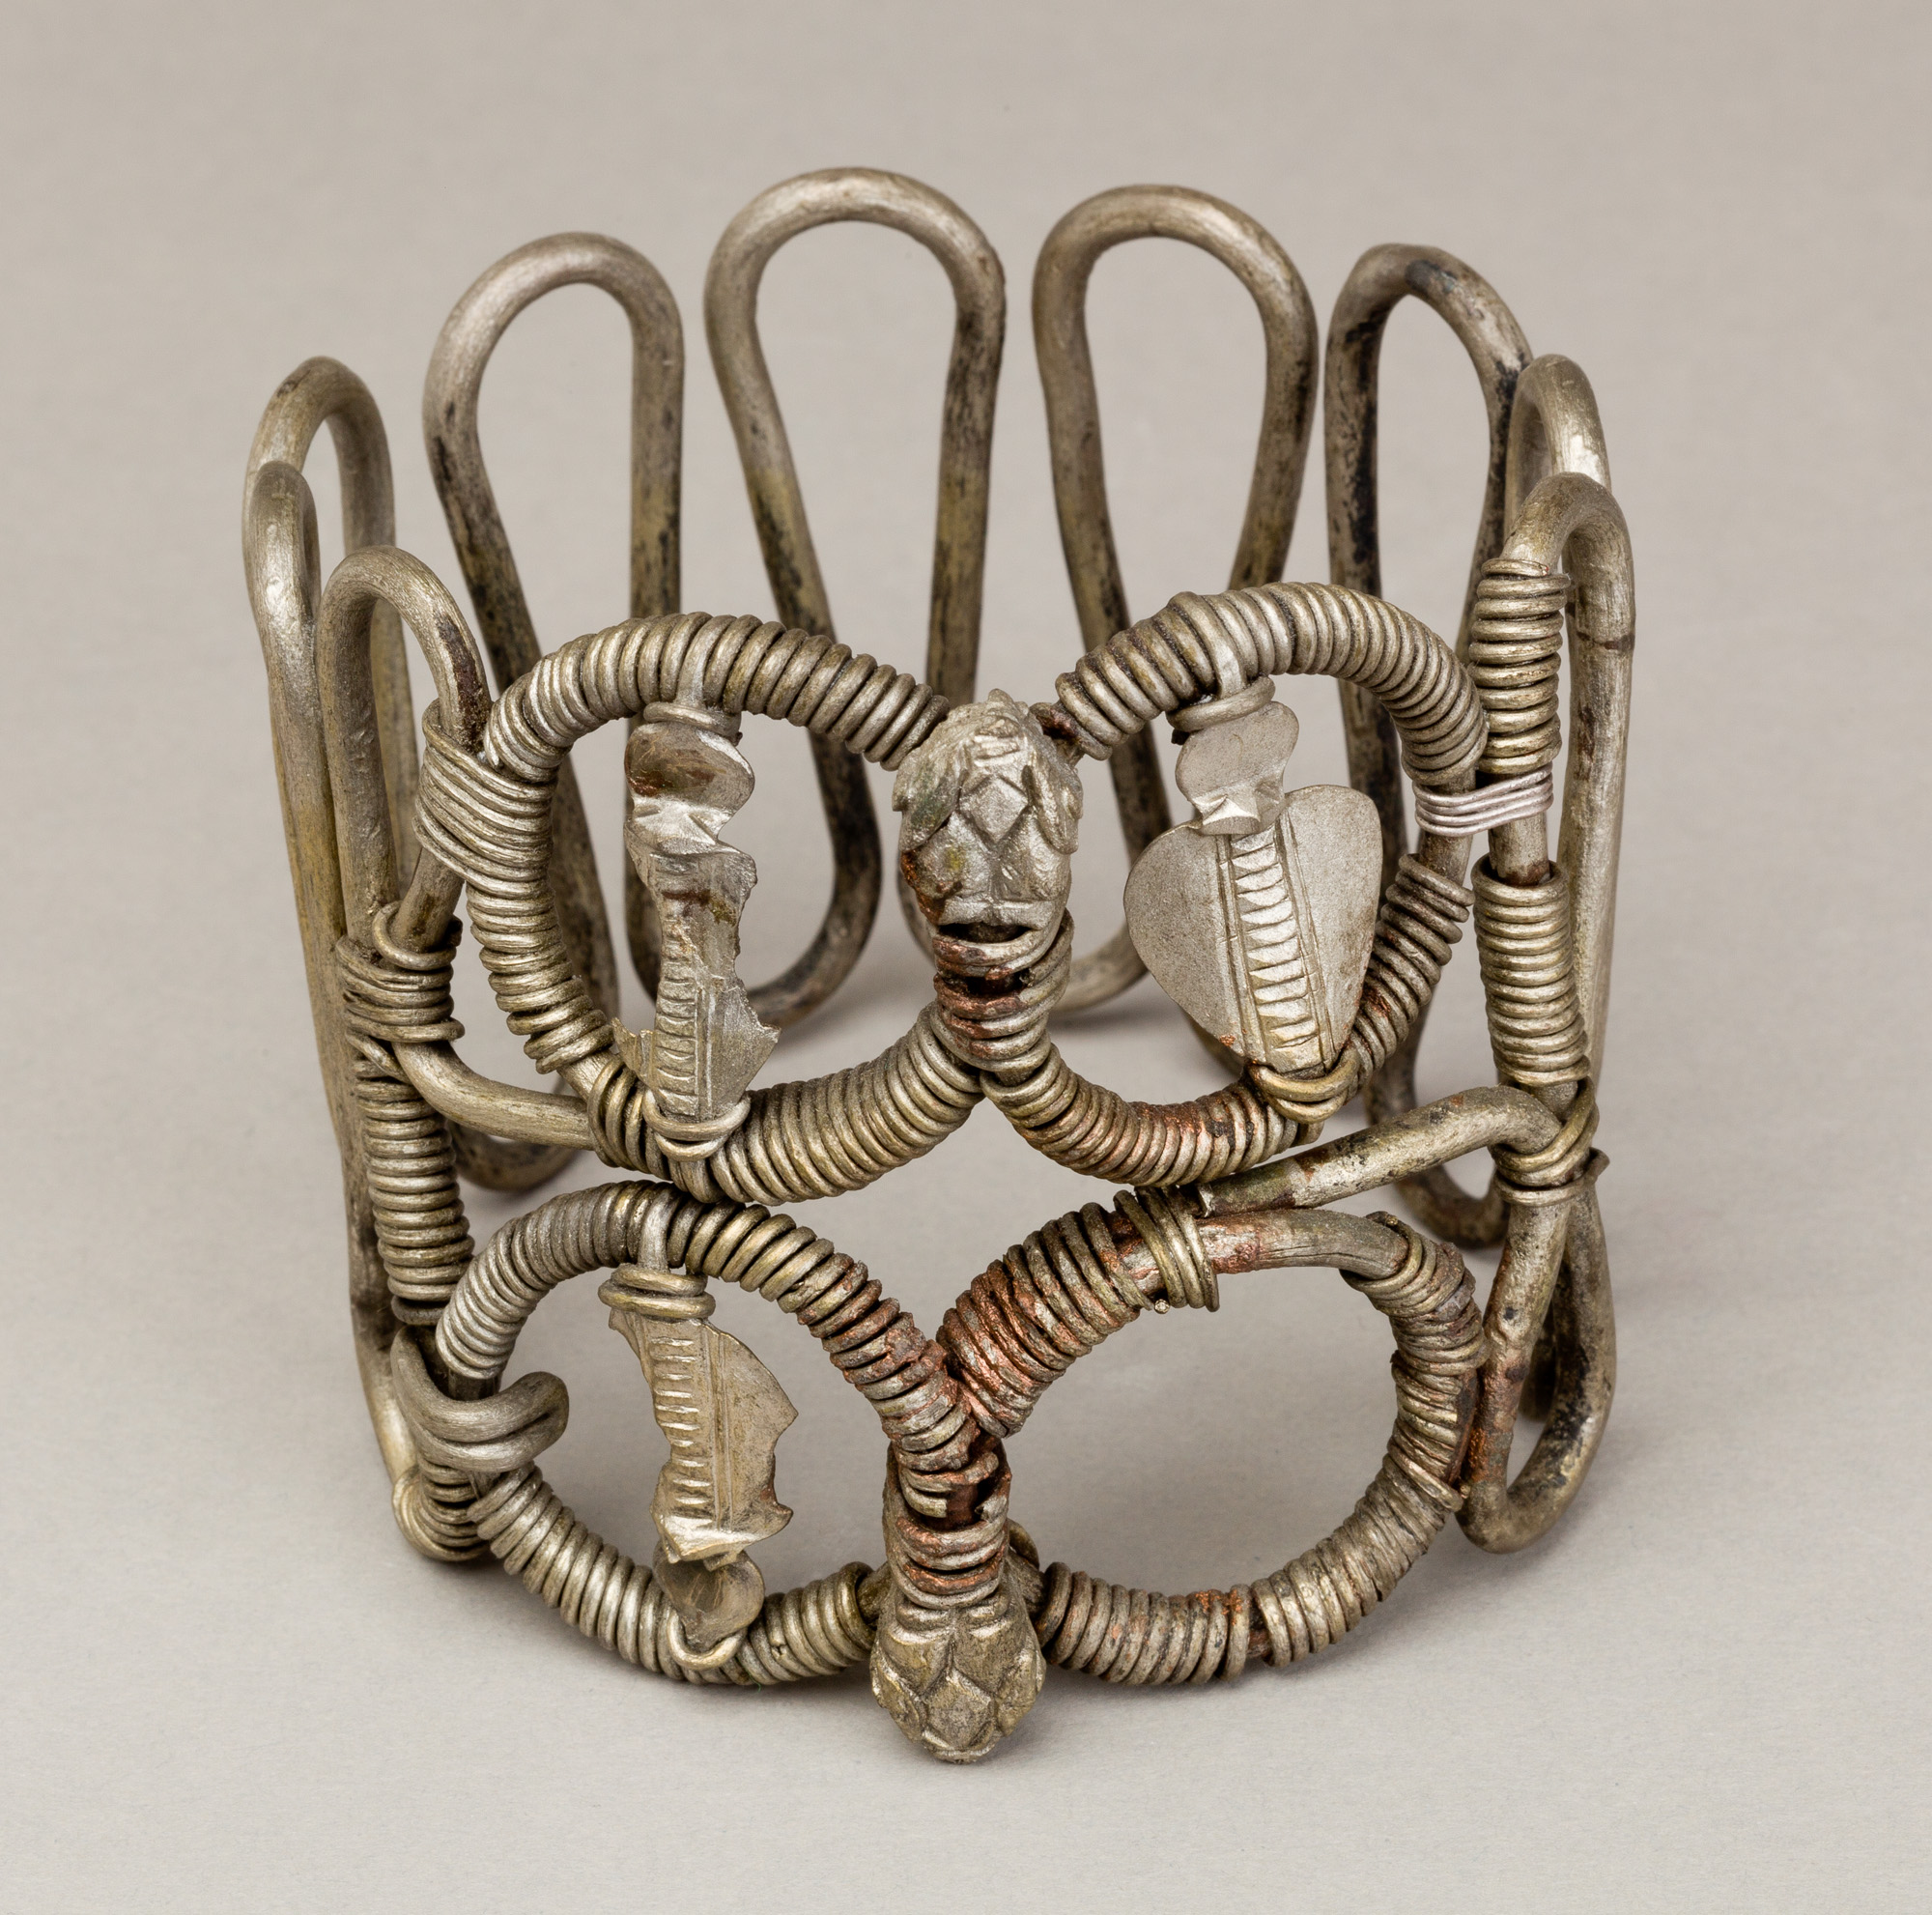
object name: bracelet or armlet, uraei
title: Bracelet or armlet with uraei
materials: silver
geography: egypt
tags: serpents